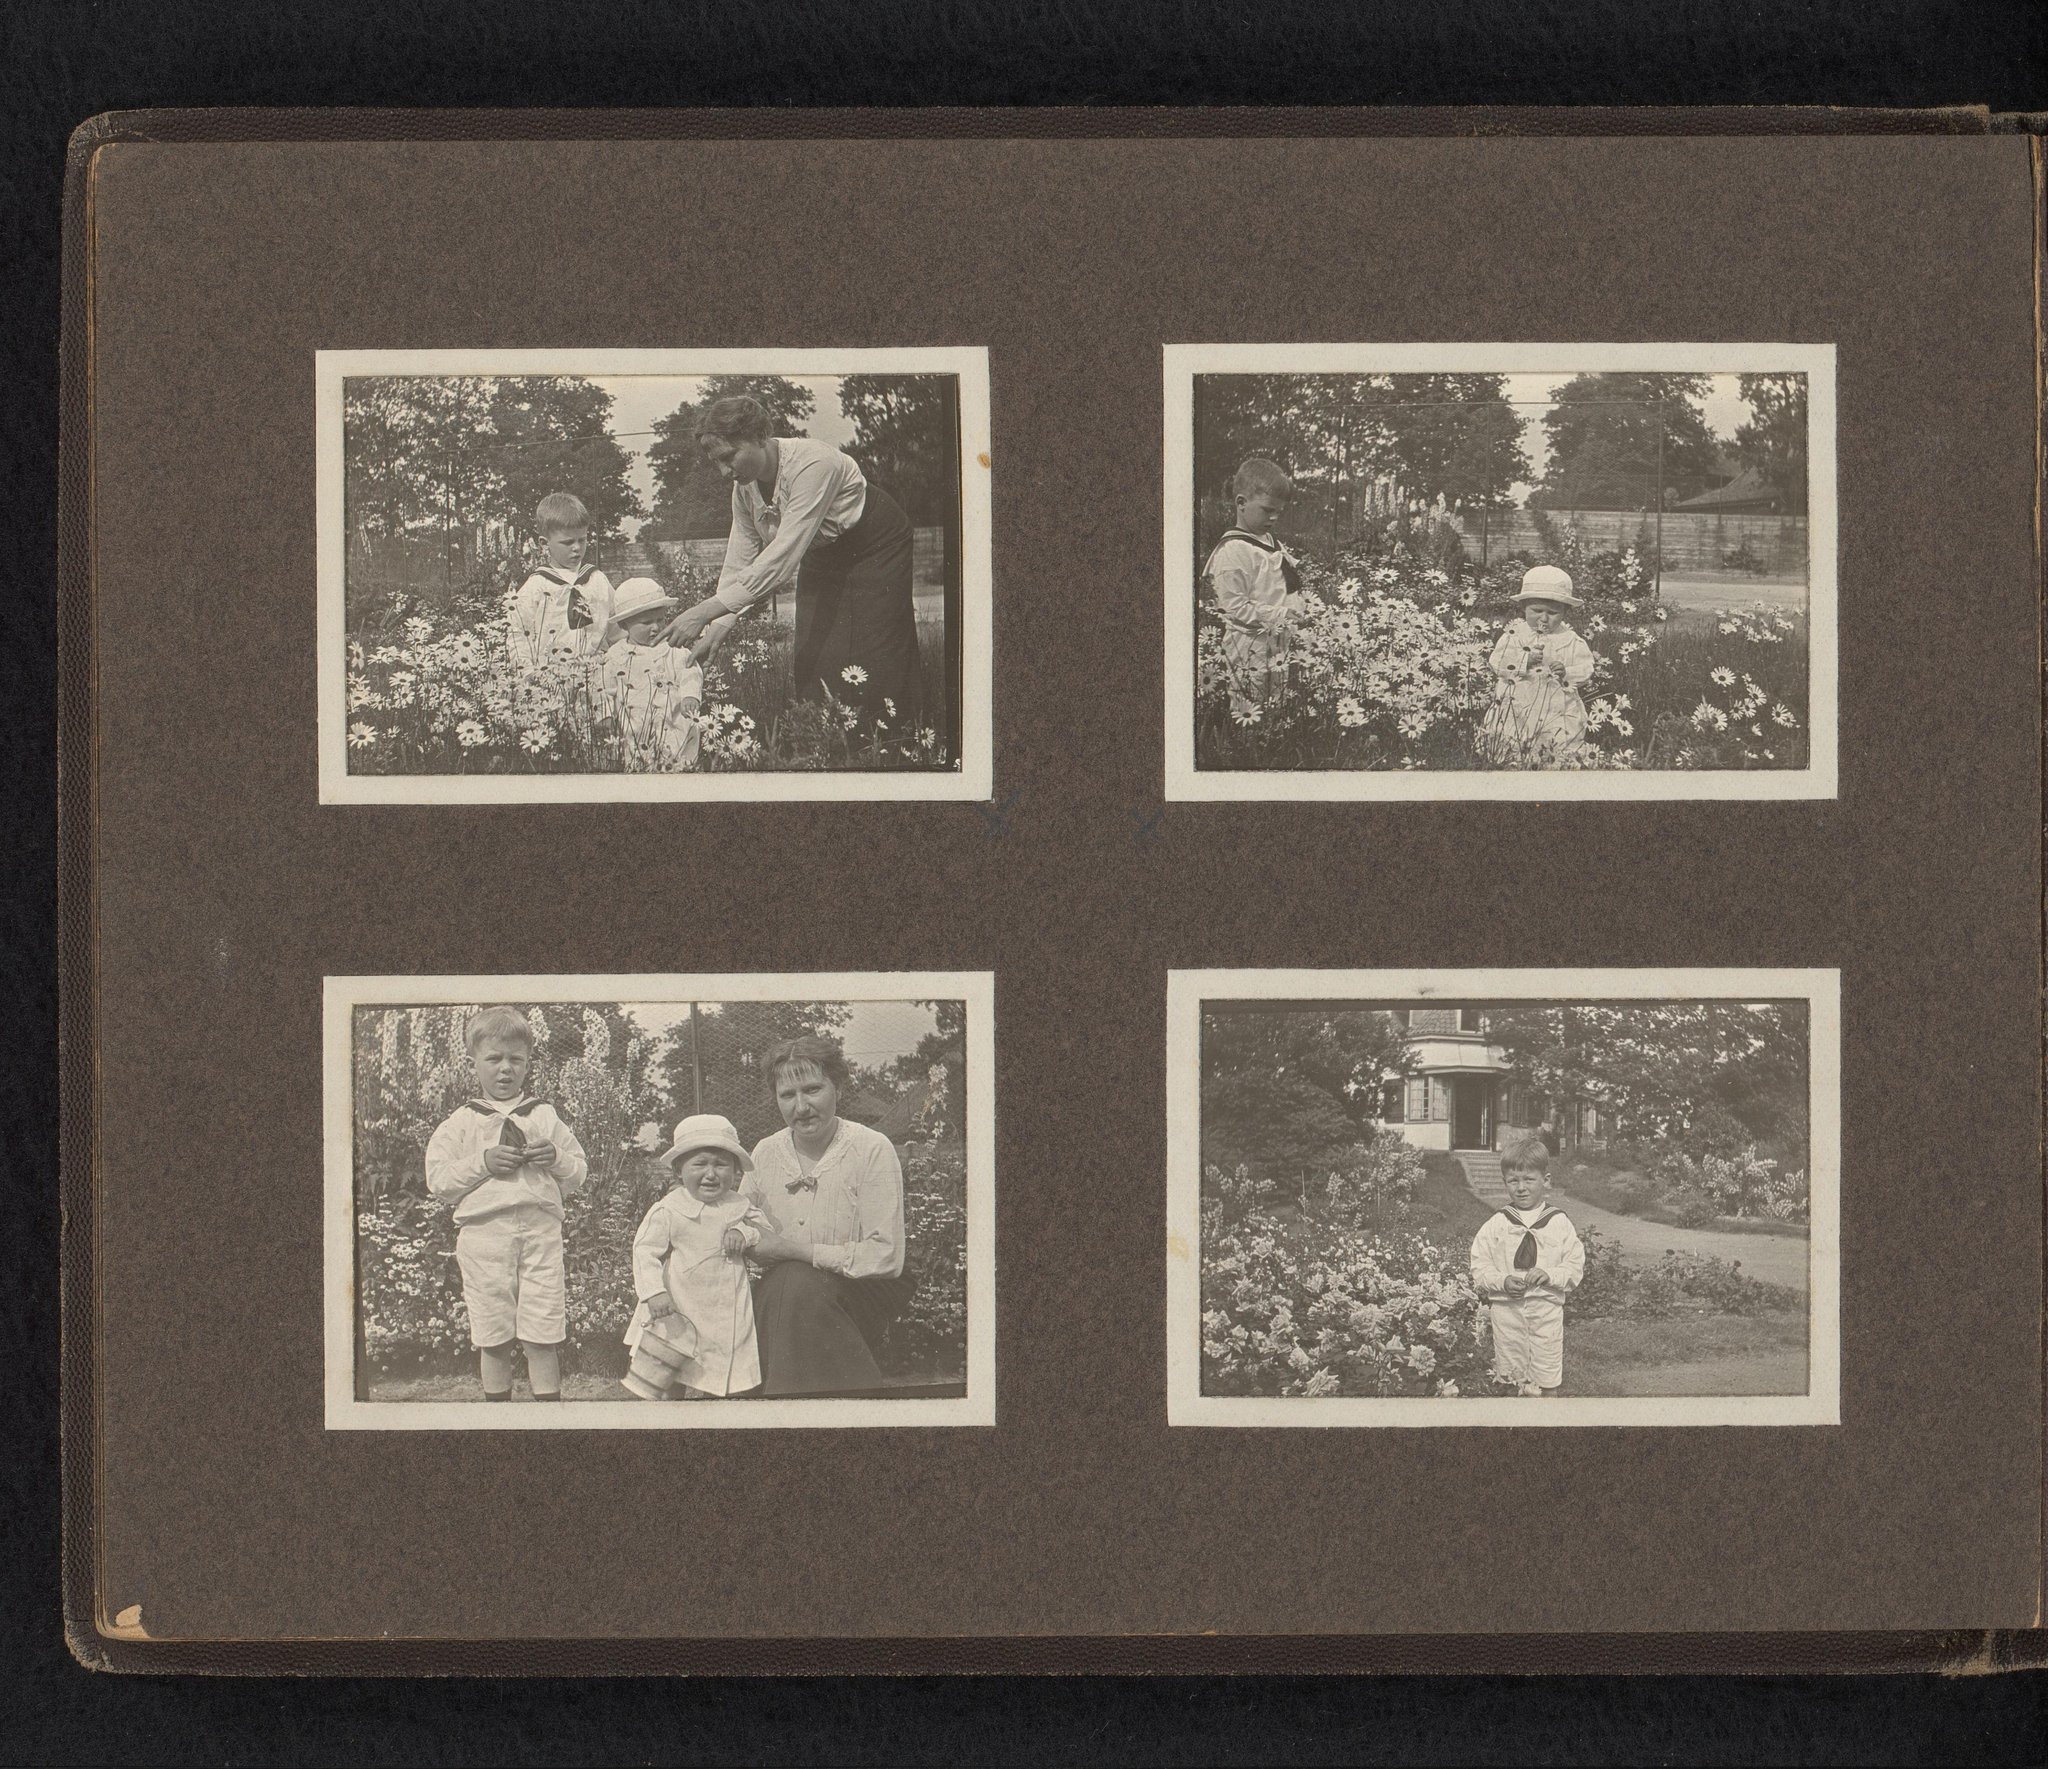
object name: photograph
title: Vier foto's van Carel Frederik en Frank Willem van den Berg met een vrouw in Bergerac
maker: hendrik herman van den berg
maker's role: amateurfotograaf, jurist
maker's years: 1875-1944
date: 1914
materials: paper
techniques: gelatin silver print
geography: bergerac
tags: amsterdam, carel frederik van den berg (cay), frank willem van den berg (1912-1998), garden, child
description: Deze foto's maken deel uit van een album.